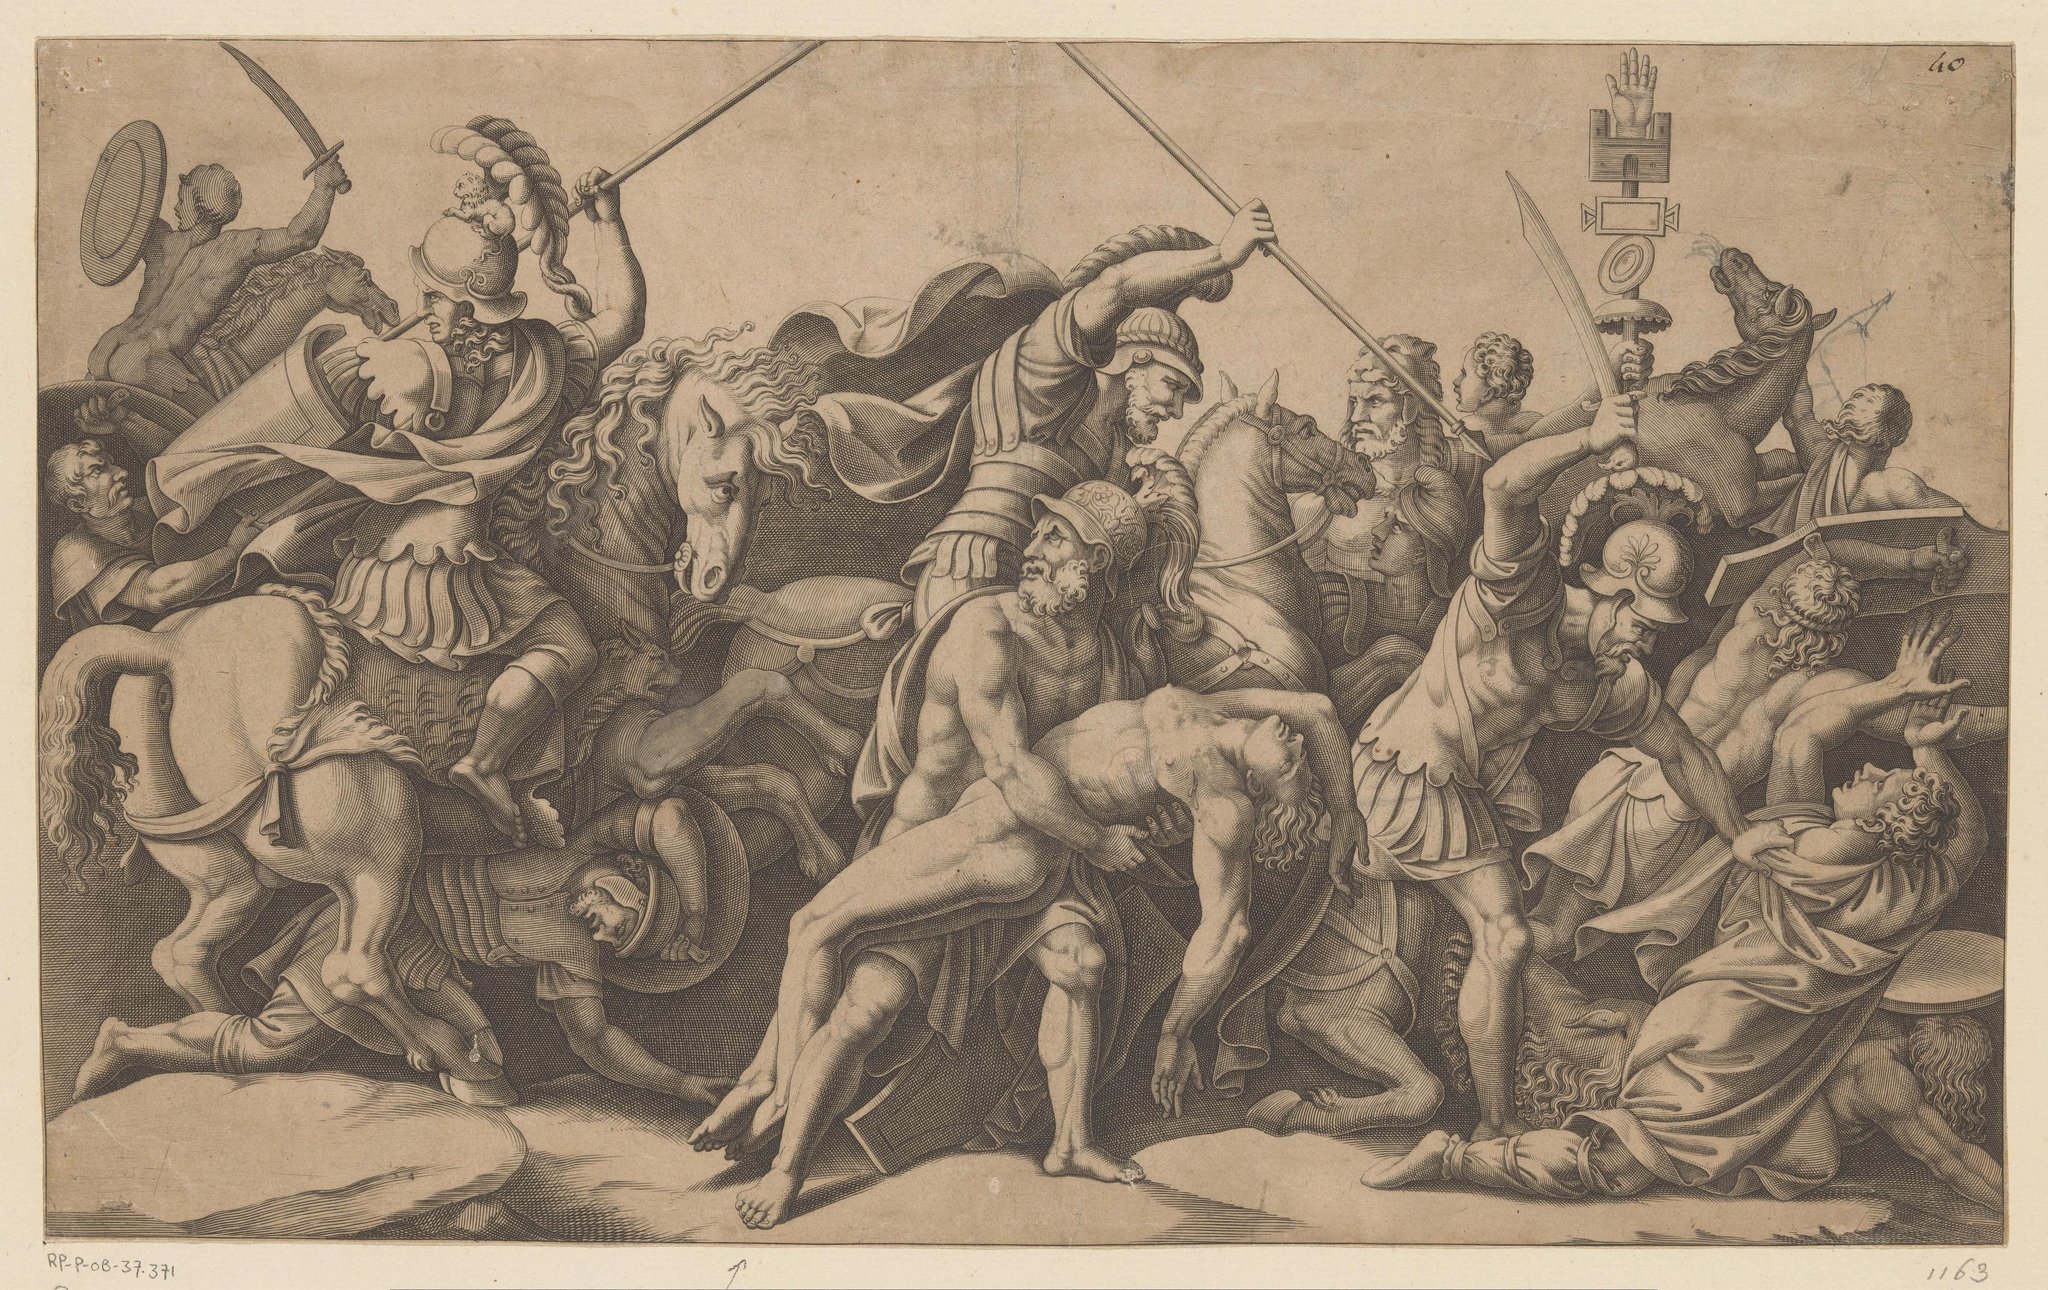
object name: print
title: Menelaus met het lichaam van Patroclus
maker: diana detto mantovano scultori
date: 1557-1612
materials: paper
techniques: engraving, intaglio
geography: italy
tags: menelaus carries patroclus' body from the battle-field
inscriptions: number: ‘40’, collector's mark: Lugt 240, inscription: ‘I x bis I R’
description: Een gevecht tussen de Spartanen en Trojanen tijdens de Trojaanse Oorlog. Op de voorgrond Menelaus, koning van Sparta, met in zijn armen de overleden Patroclus.